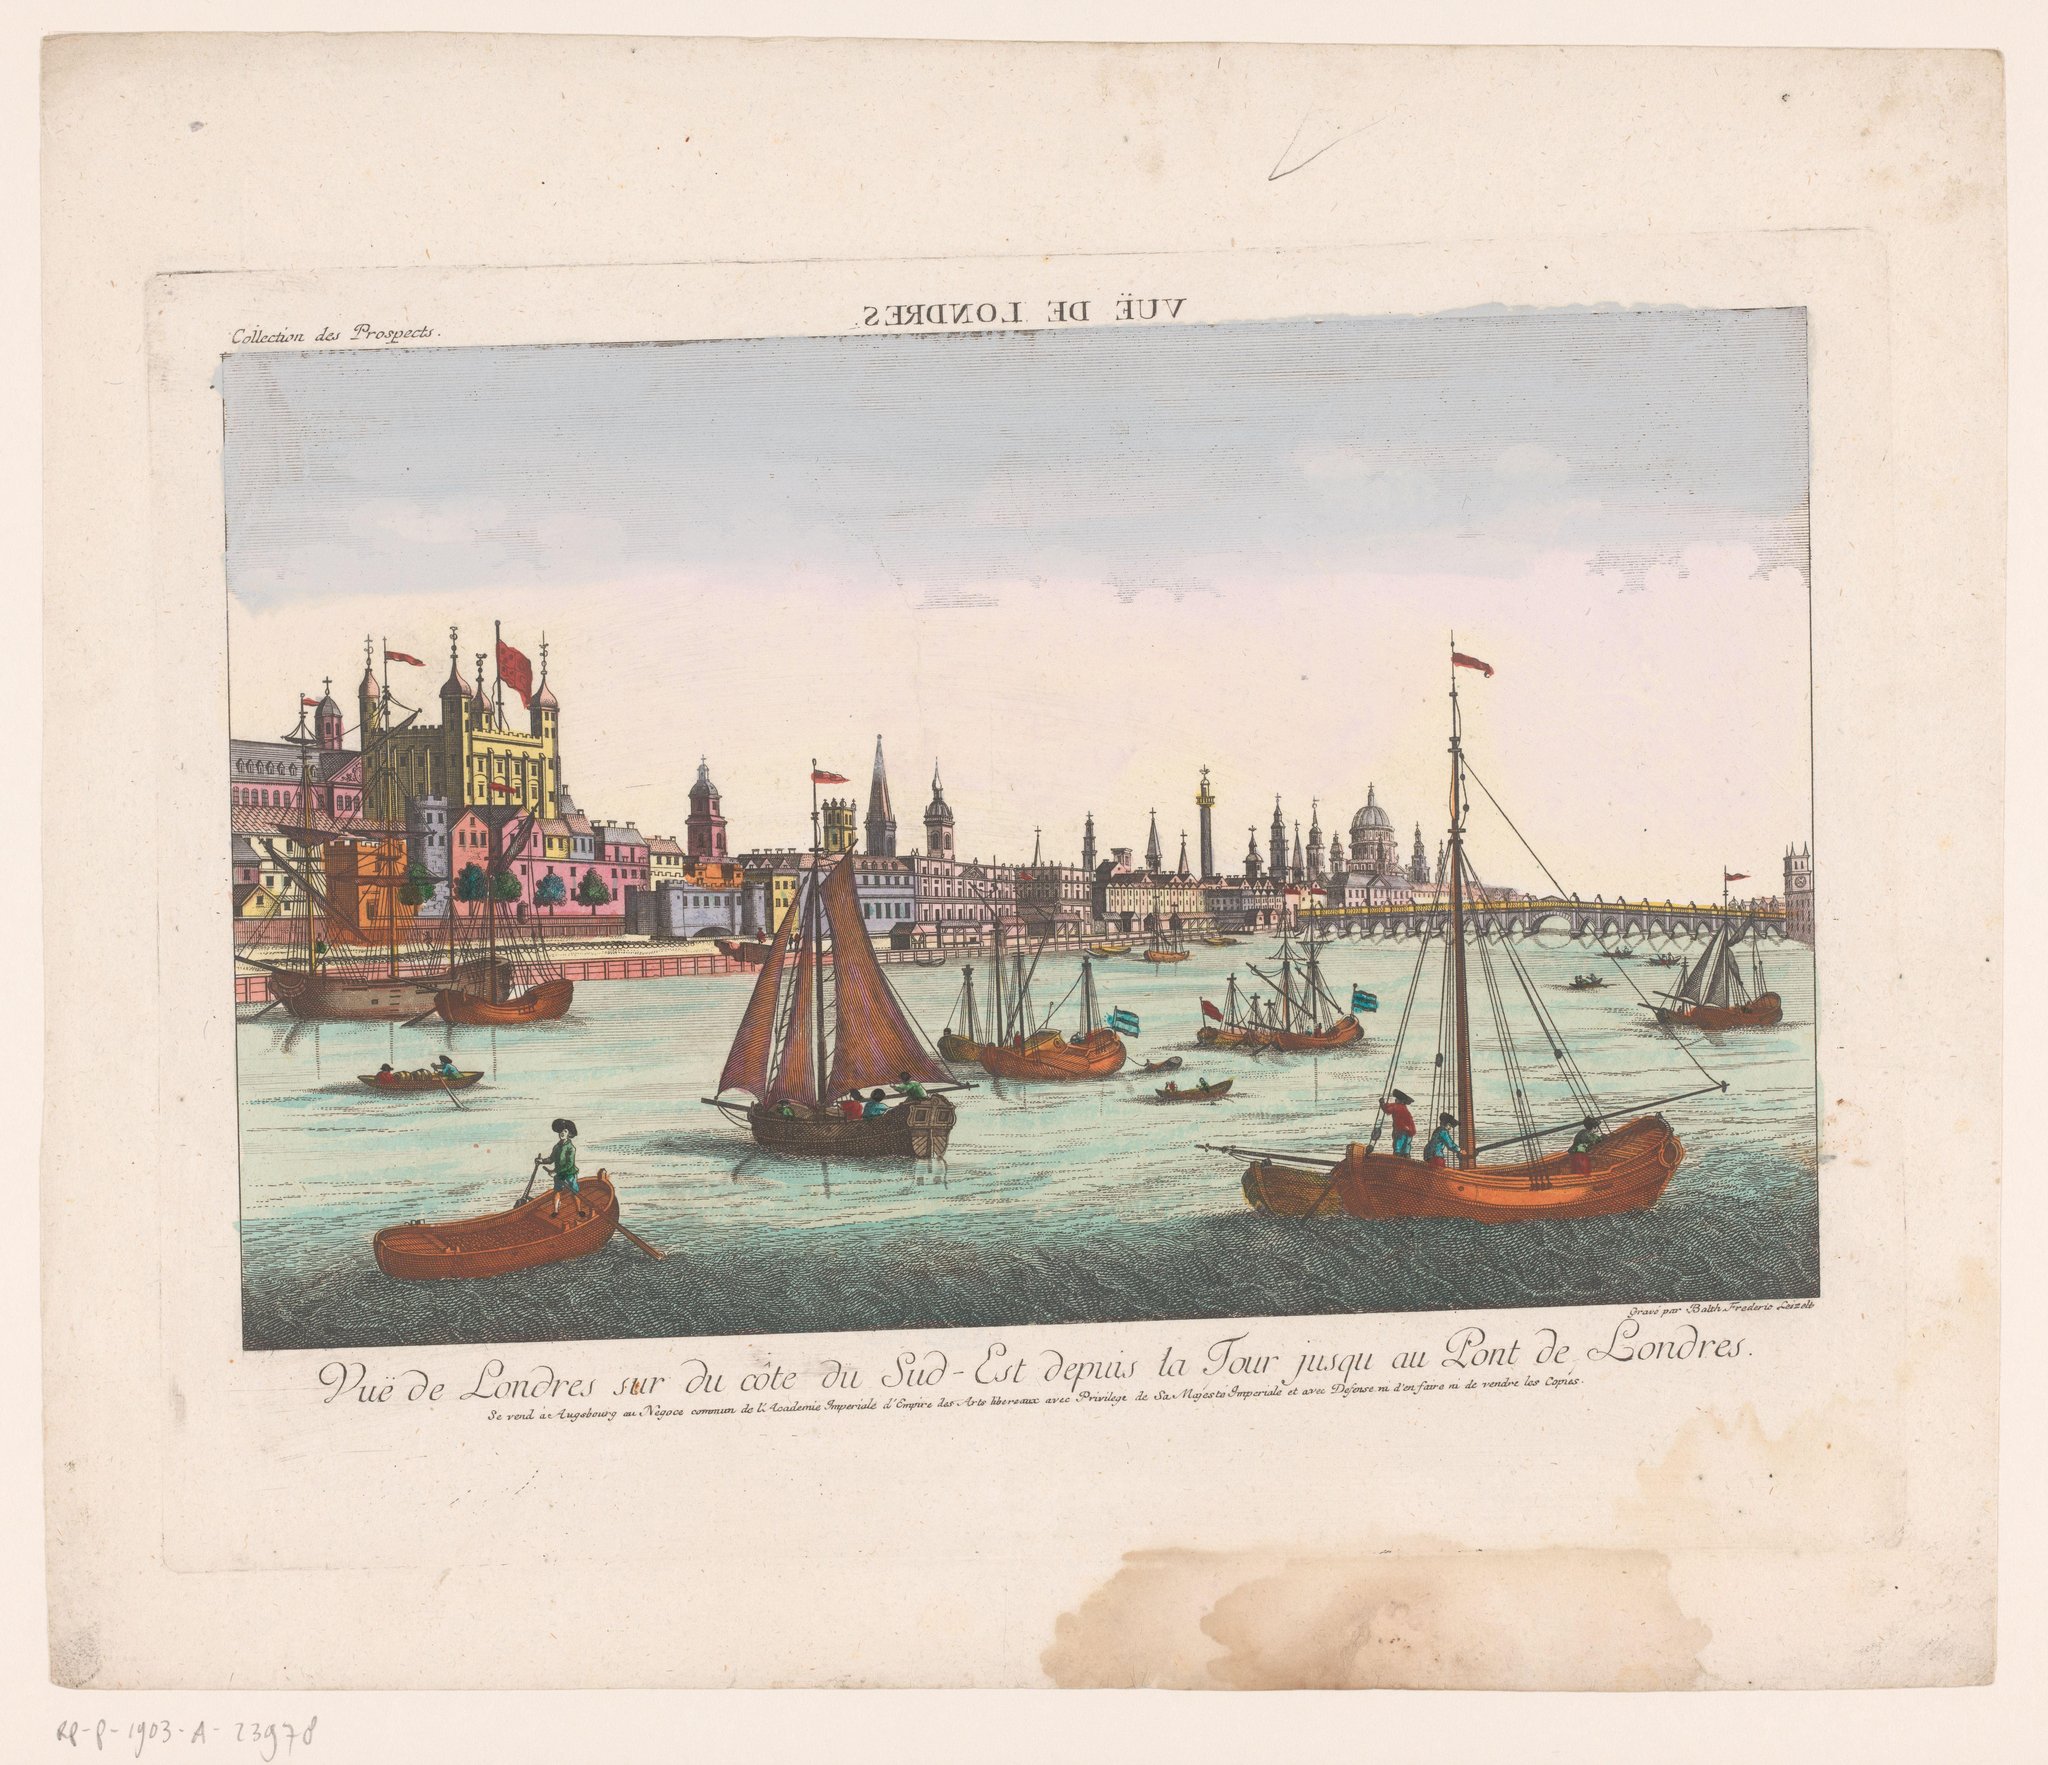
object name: opticaprent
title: Gezicht op Londen vanaf de Thames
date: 1755-1779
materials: paper, watercolor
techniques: brush, etching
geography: augsburg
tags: bridge in city across river, canal, etc. (+ city(-scape) with figures, staffage), city-view in general; 'veduta', monumental adornments (in city), london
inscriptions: collector's mark: Lugt 2228